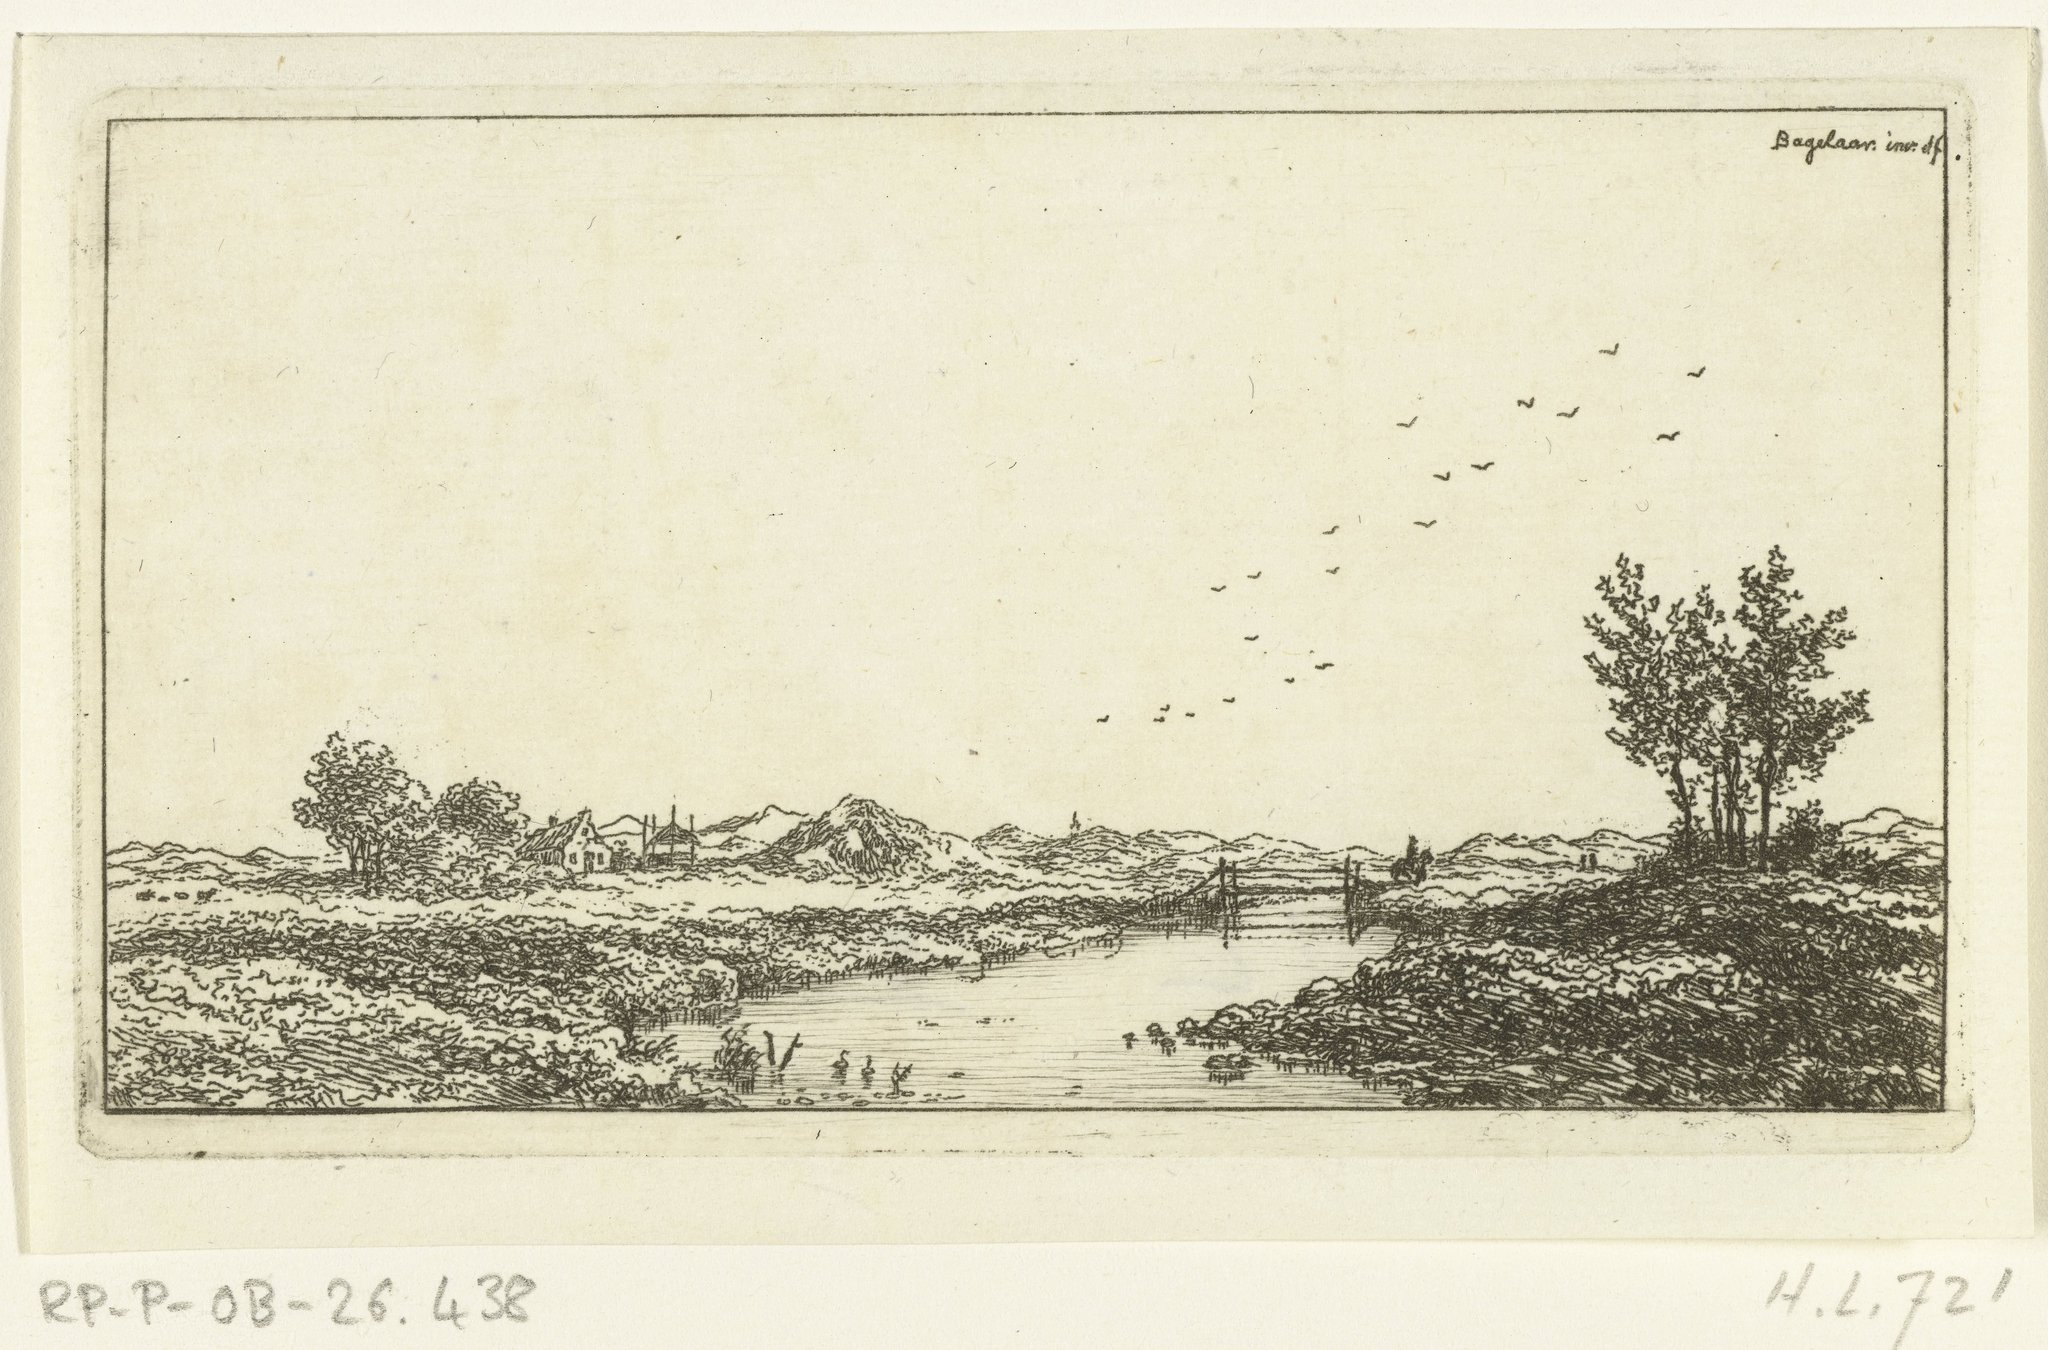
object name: print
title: Rivierlandschap met ruiter bij een brug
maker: ernst willem jan bagelaar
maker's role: draughtsman, print maker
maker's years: 1775-1837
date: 1798-1837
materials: paper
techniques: etching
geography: netherlands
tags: landscapes with waters, waterscapes, seascapes (in the temperate zone) (+ landscape with figures, staffage)